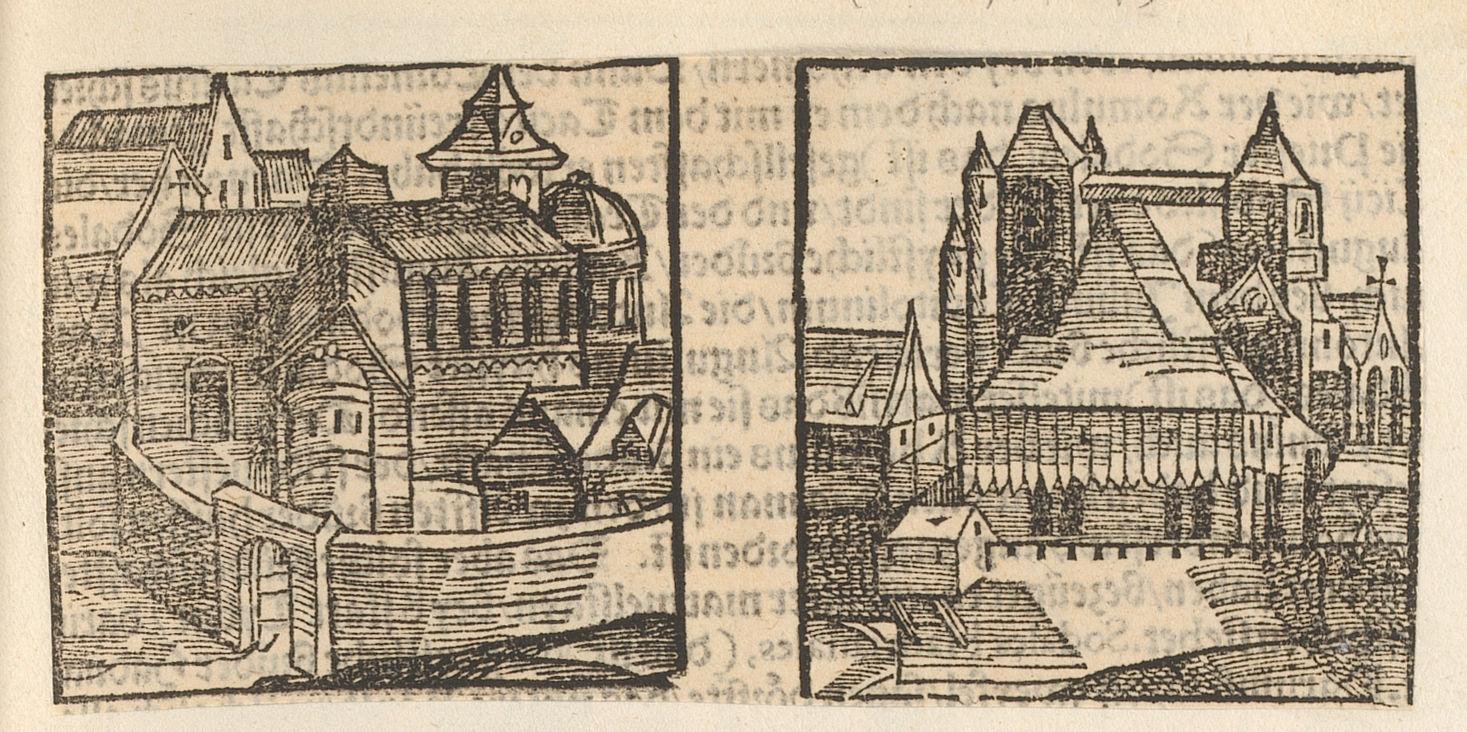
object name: album leaf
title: Twee stadsgezichten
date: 1490-1537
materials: paper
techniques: letterpress printing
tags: city-view in general; 'veduta'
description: Deze prent is mogelijk gebruikt in: Petrarca, Francesco. Von der Artzney bayder Glück, des guten und widerwertigen: unnd weß sich ain yeder inn Gelück und Unglück halten sol (...). Augsburg: Heinrich Steiner, 1532. Deze uitgave is ook bekend onder de titel 'Trostspiegel in Glück und Unglück'.